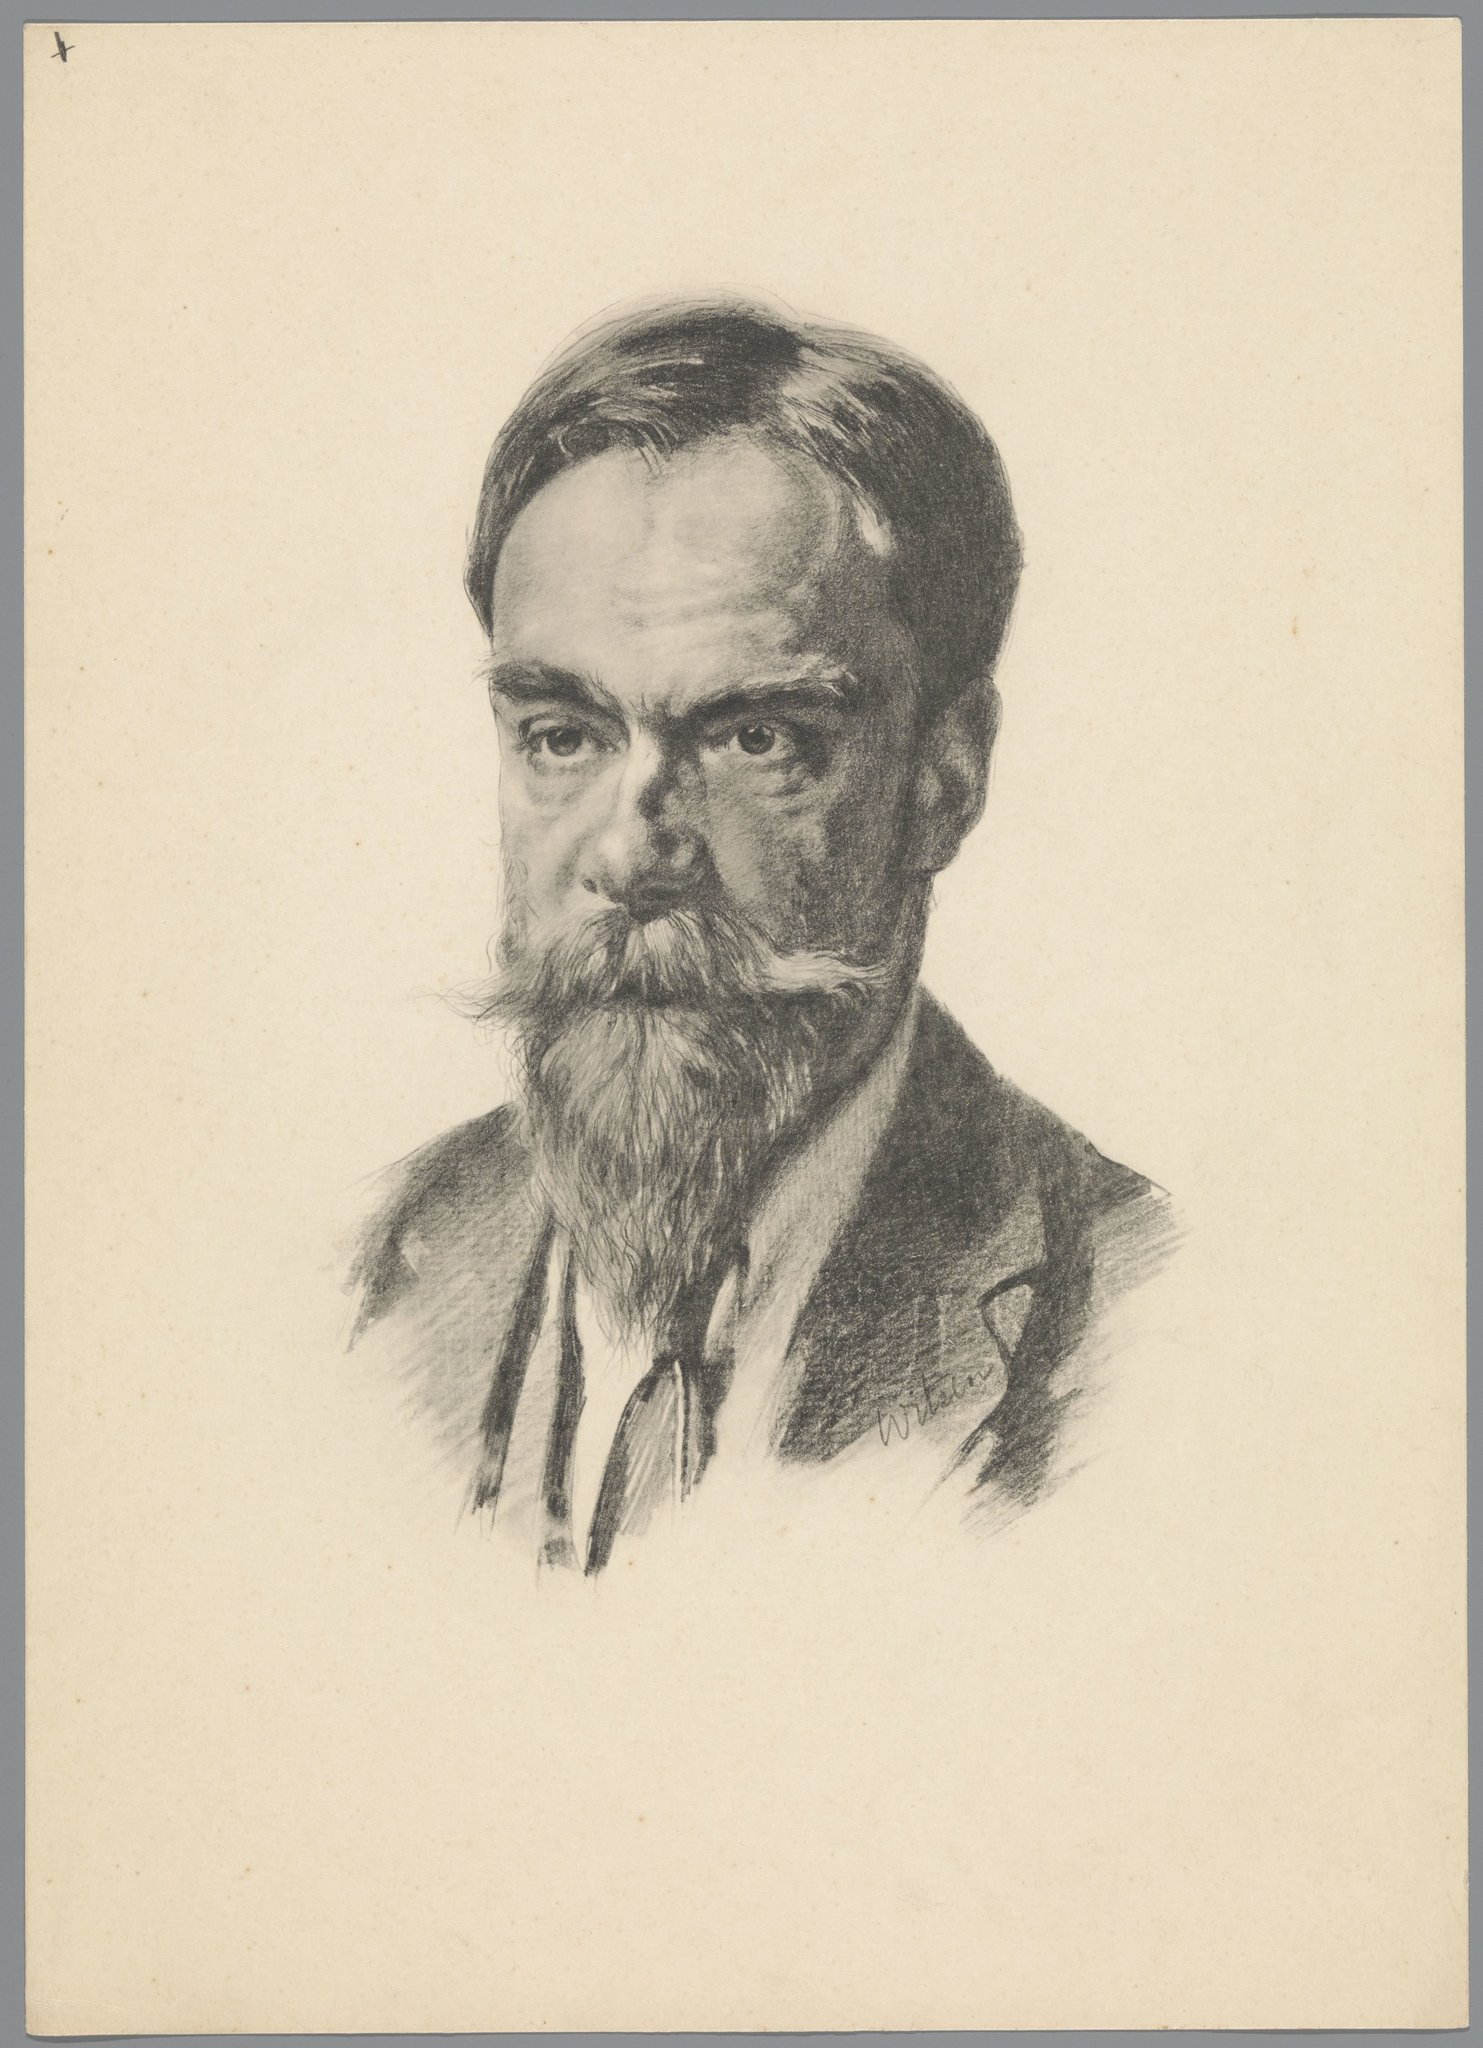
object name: print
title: Reproductie naar krijttekening met portret van Frans Coenen Jr.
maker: Anonymous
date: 1860-1915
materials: paper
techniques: photograph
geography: netherlands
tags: frans coenen (1866-1936)